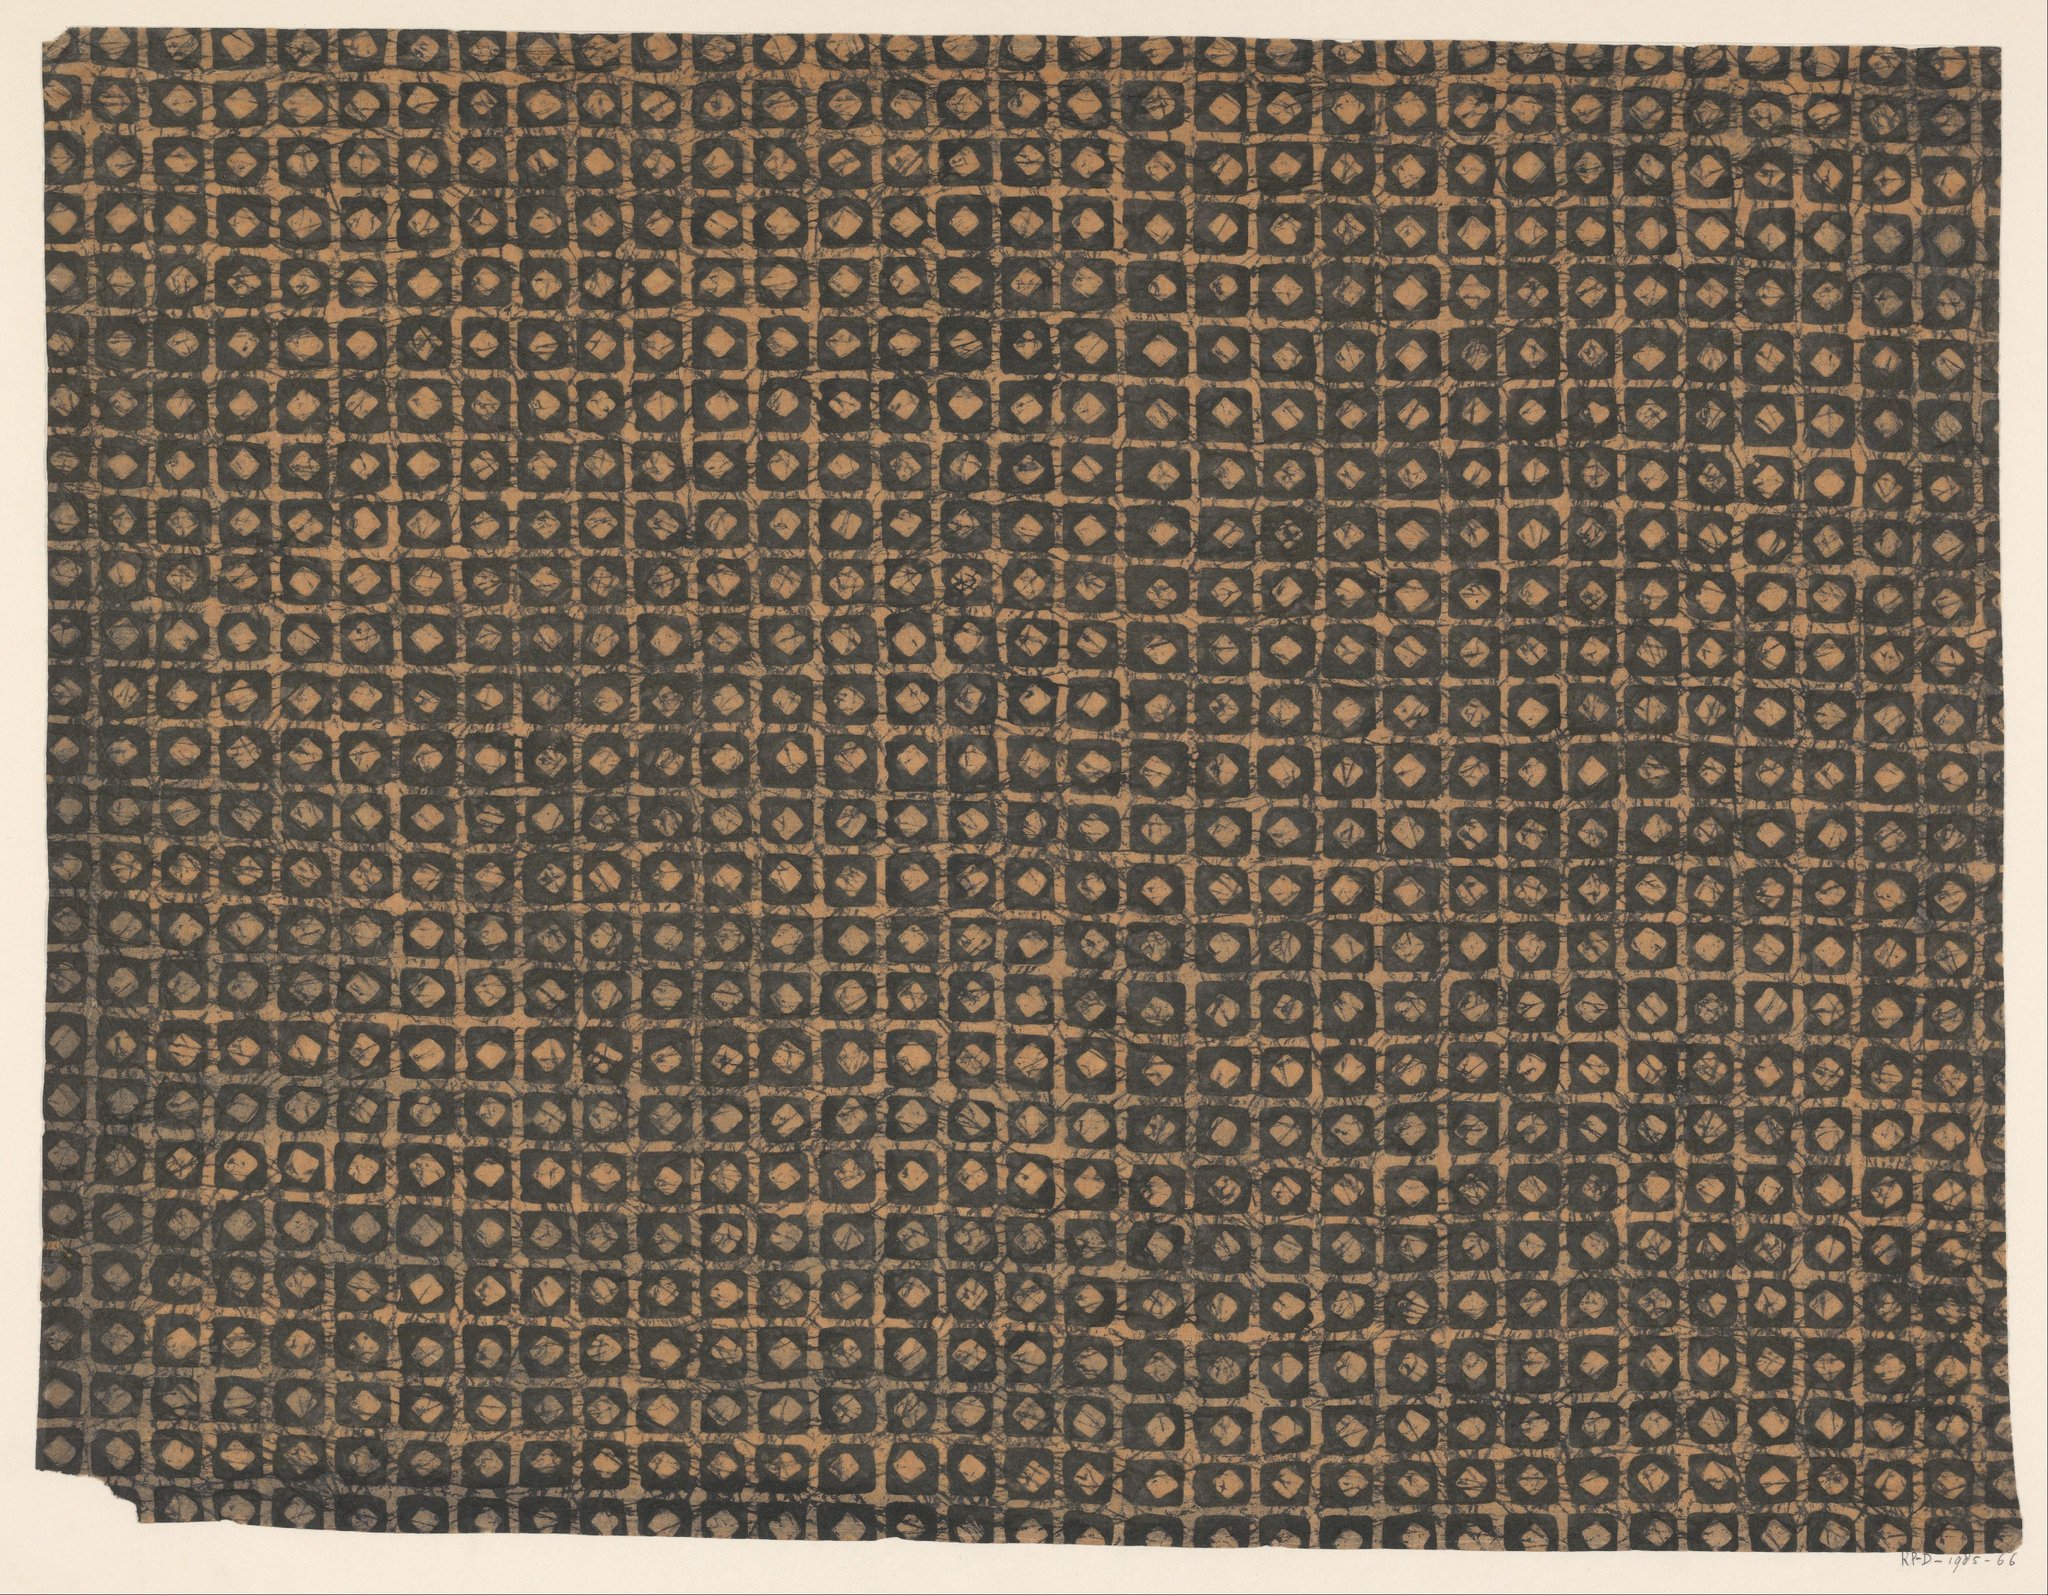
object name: decorated paper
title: Batikpapier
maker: Anonymous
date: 1900-1950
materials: paint, paper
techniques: printing block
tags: ornament ~ geometric motifs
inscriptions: collector's mark: Lugt 2228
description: Batikpapier met patroon van vierkanten met ruit als vlakvulling.